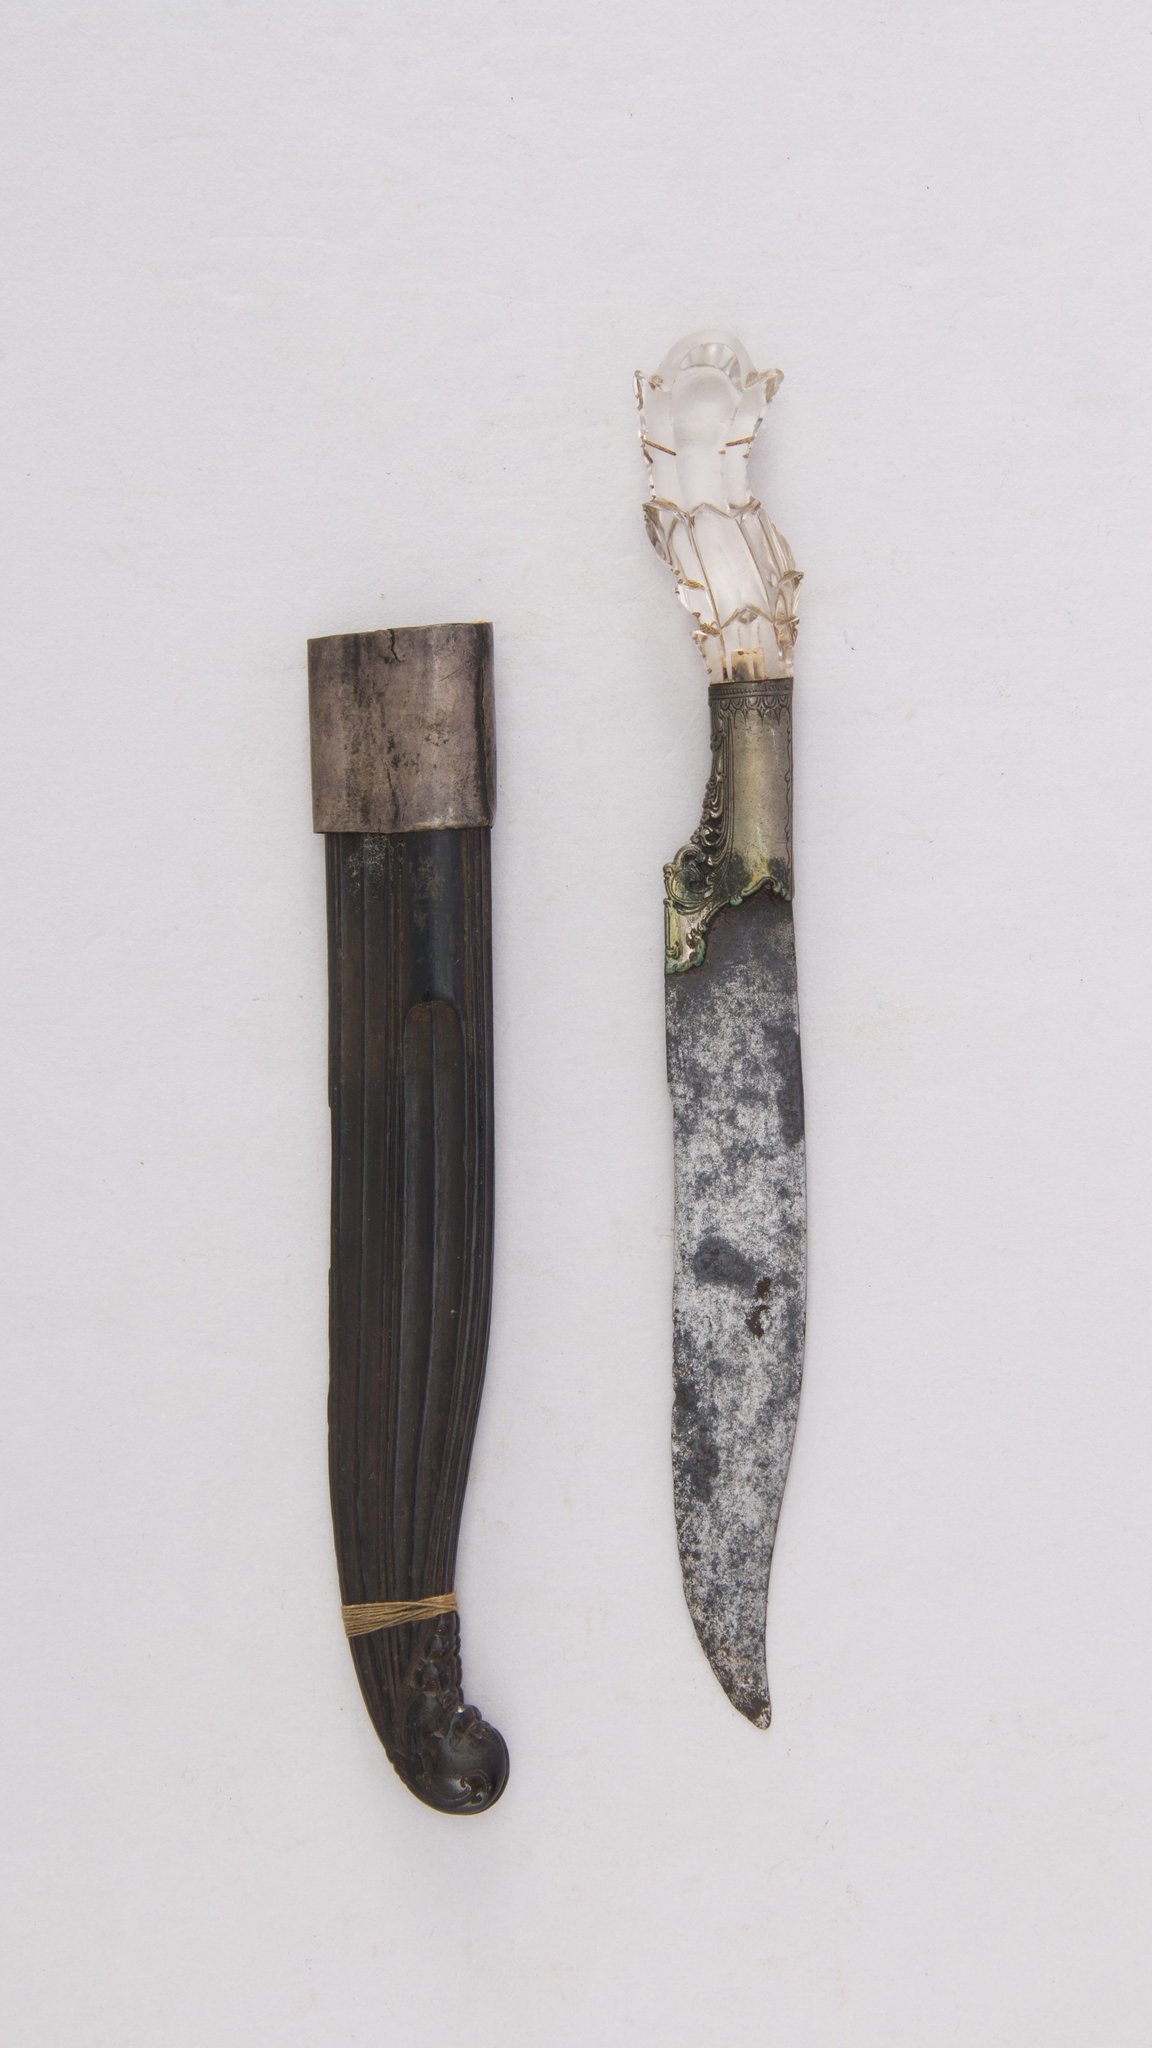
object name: knife piha kaetta with sheath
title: Knife (Piha Kaetta) with Sheath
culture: sri lankan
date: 1701-1900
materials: crystal, silver, steel, wood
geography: sri lanka